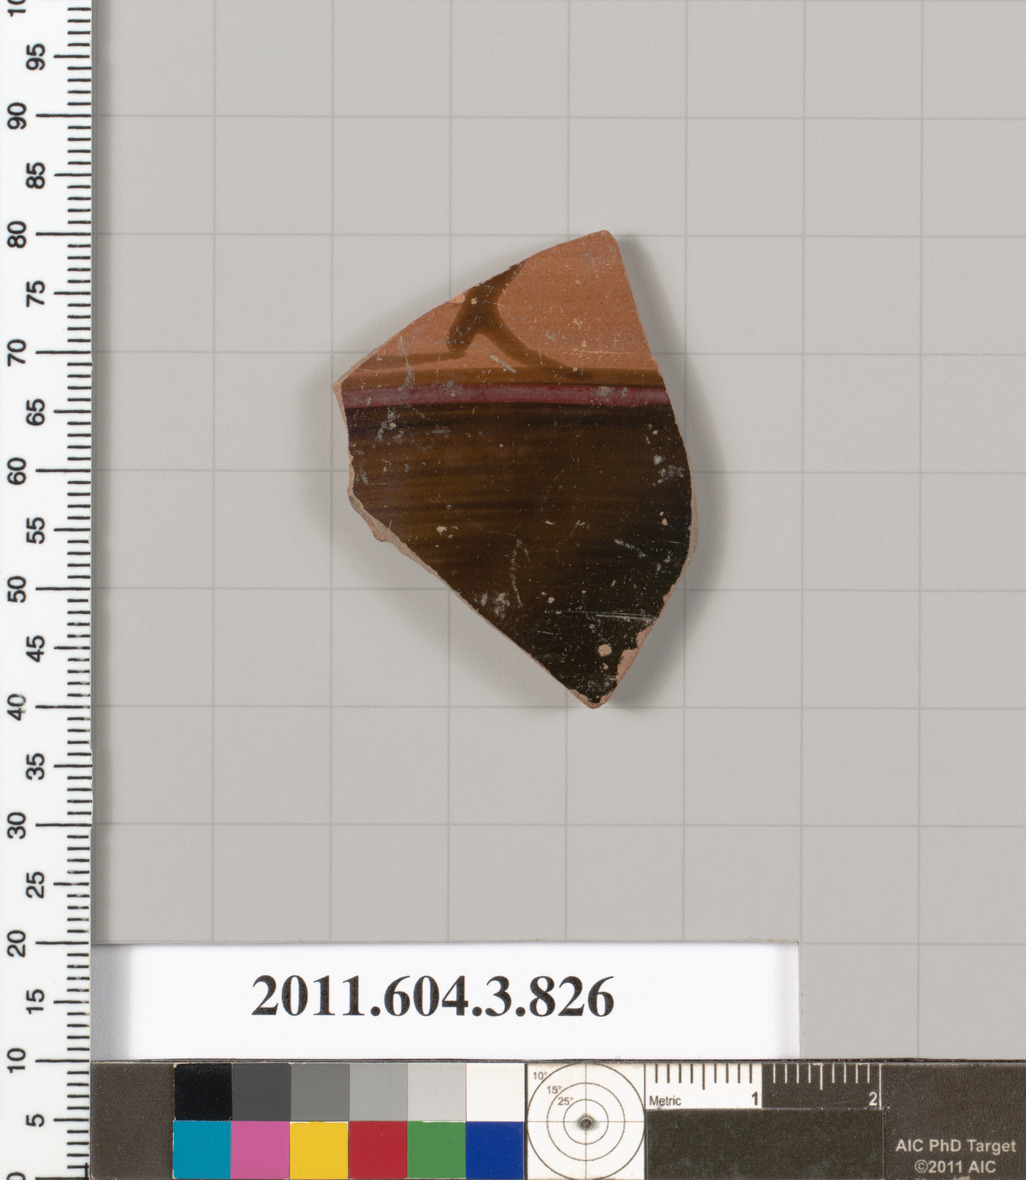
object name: lekythos fragment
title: Terracotta fragment of a lekythos (oil flask)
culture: greek, attic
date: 500-468 BCE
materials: terracotta